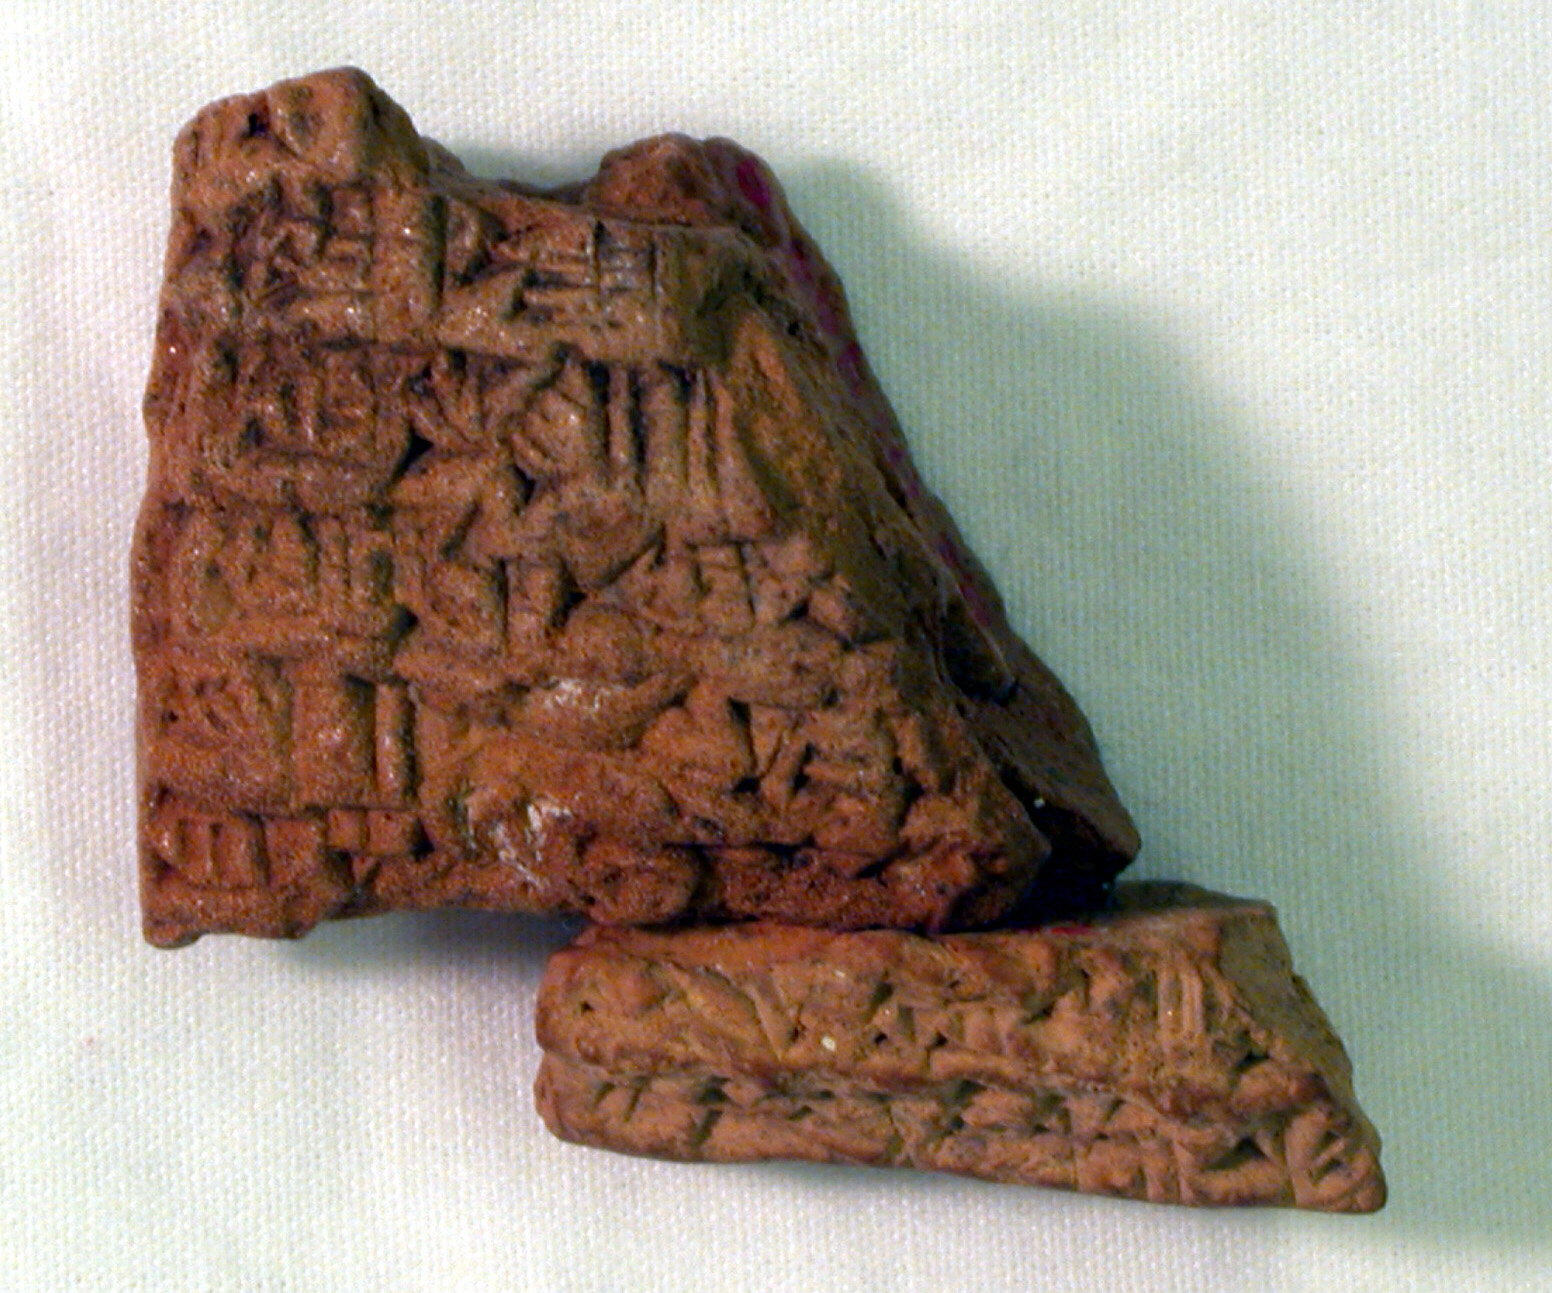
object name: cuneiform tablet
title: Cuneiform tablet: promissory note for silver, Esagilaya archive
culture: achaemenid or babylonian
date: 600-501 BCE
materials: clay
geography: mesopotamia